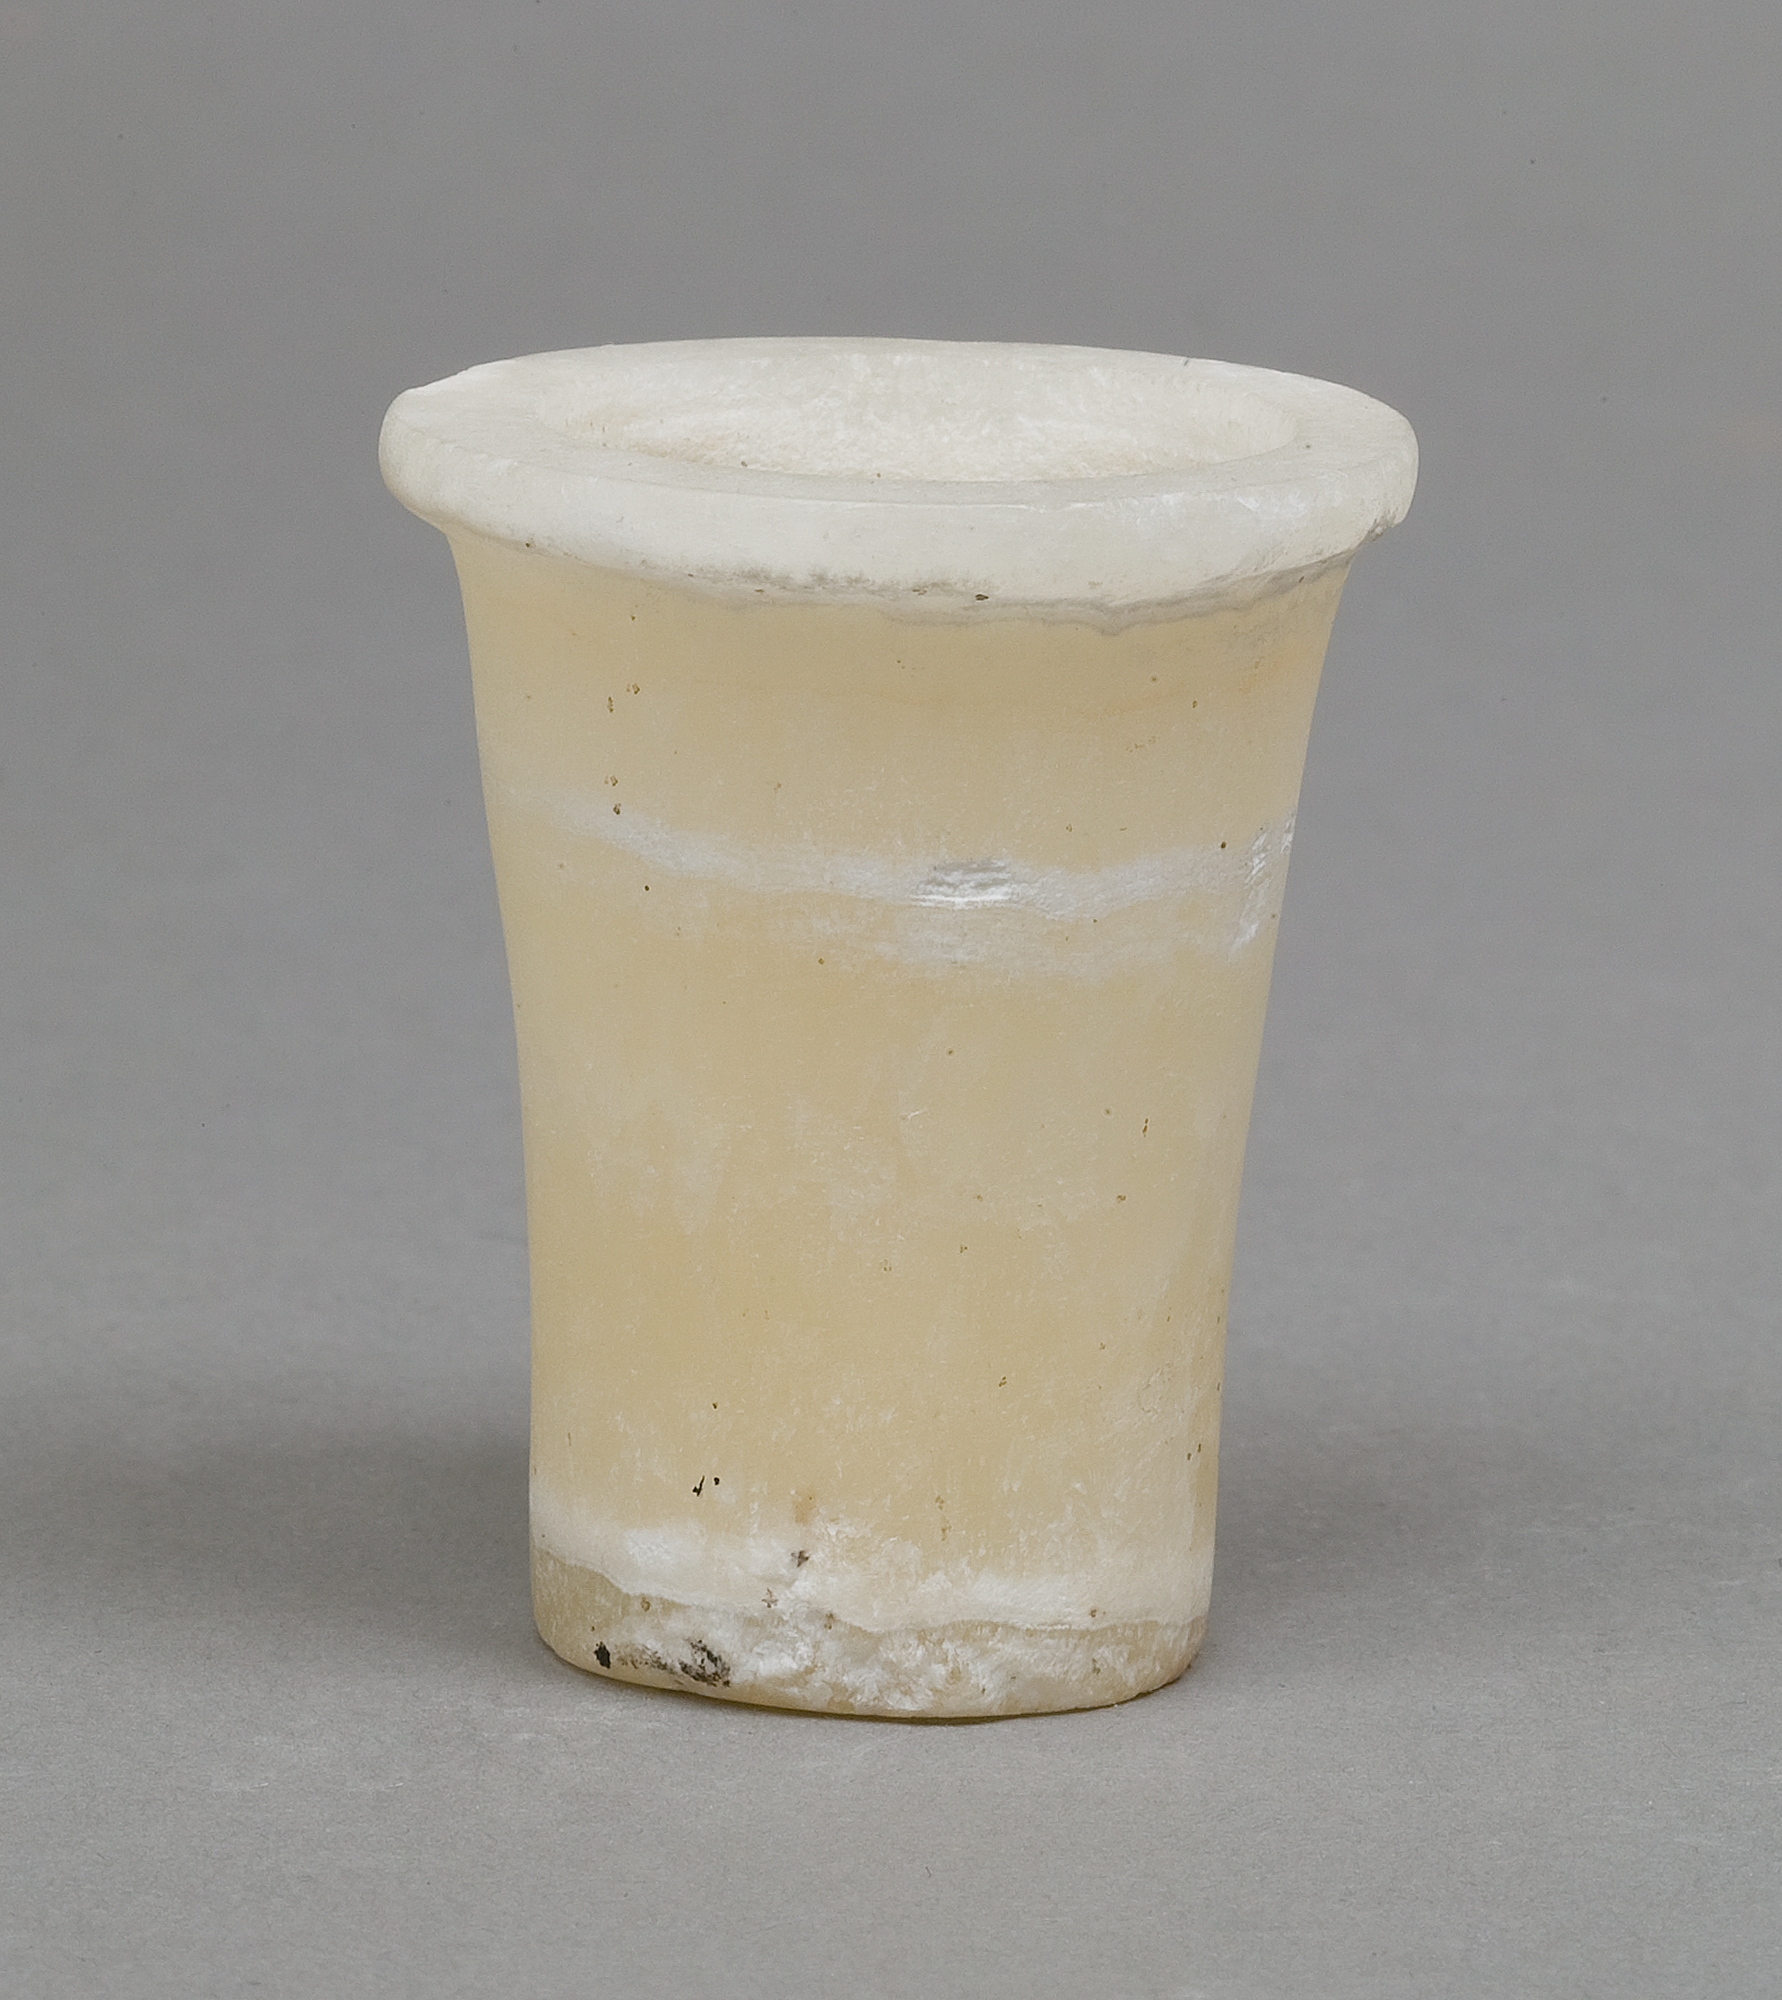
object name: jar, oil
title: Senwosret (?), Oil jar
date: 1950-1850 BCE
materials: stone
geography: egypt